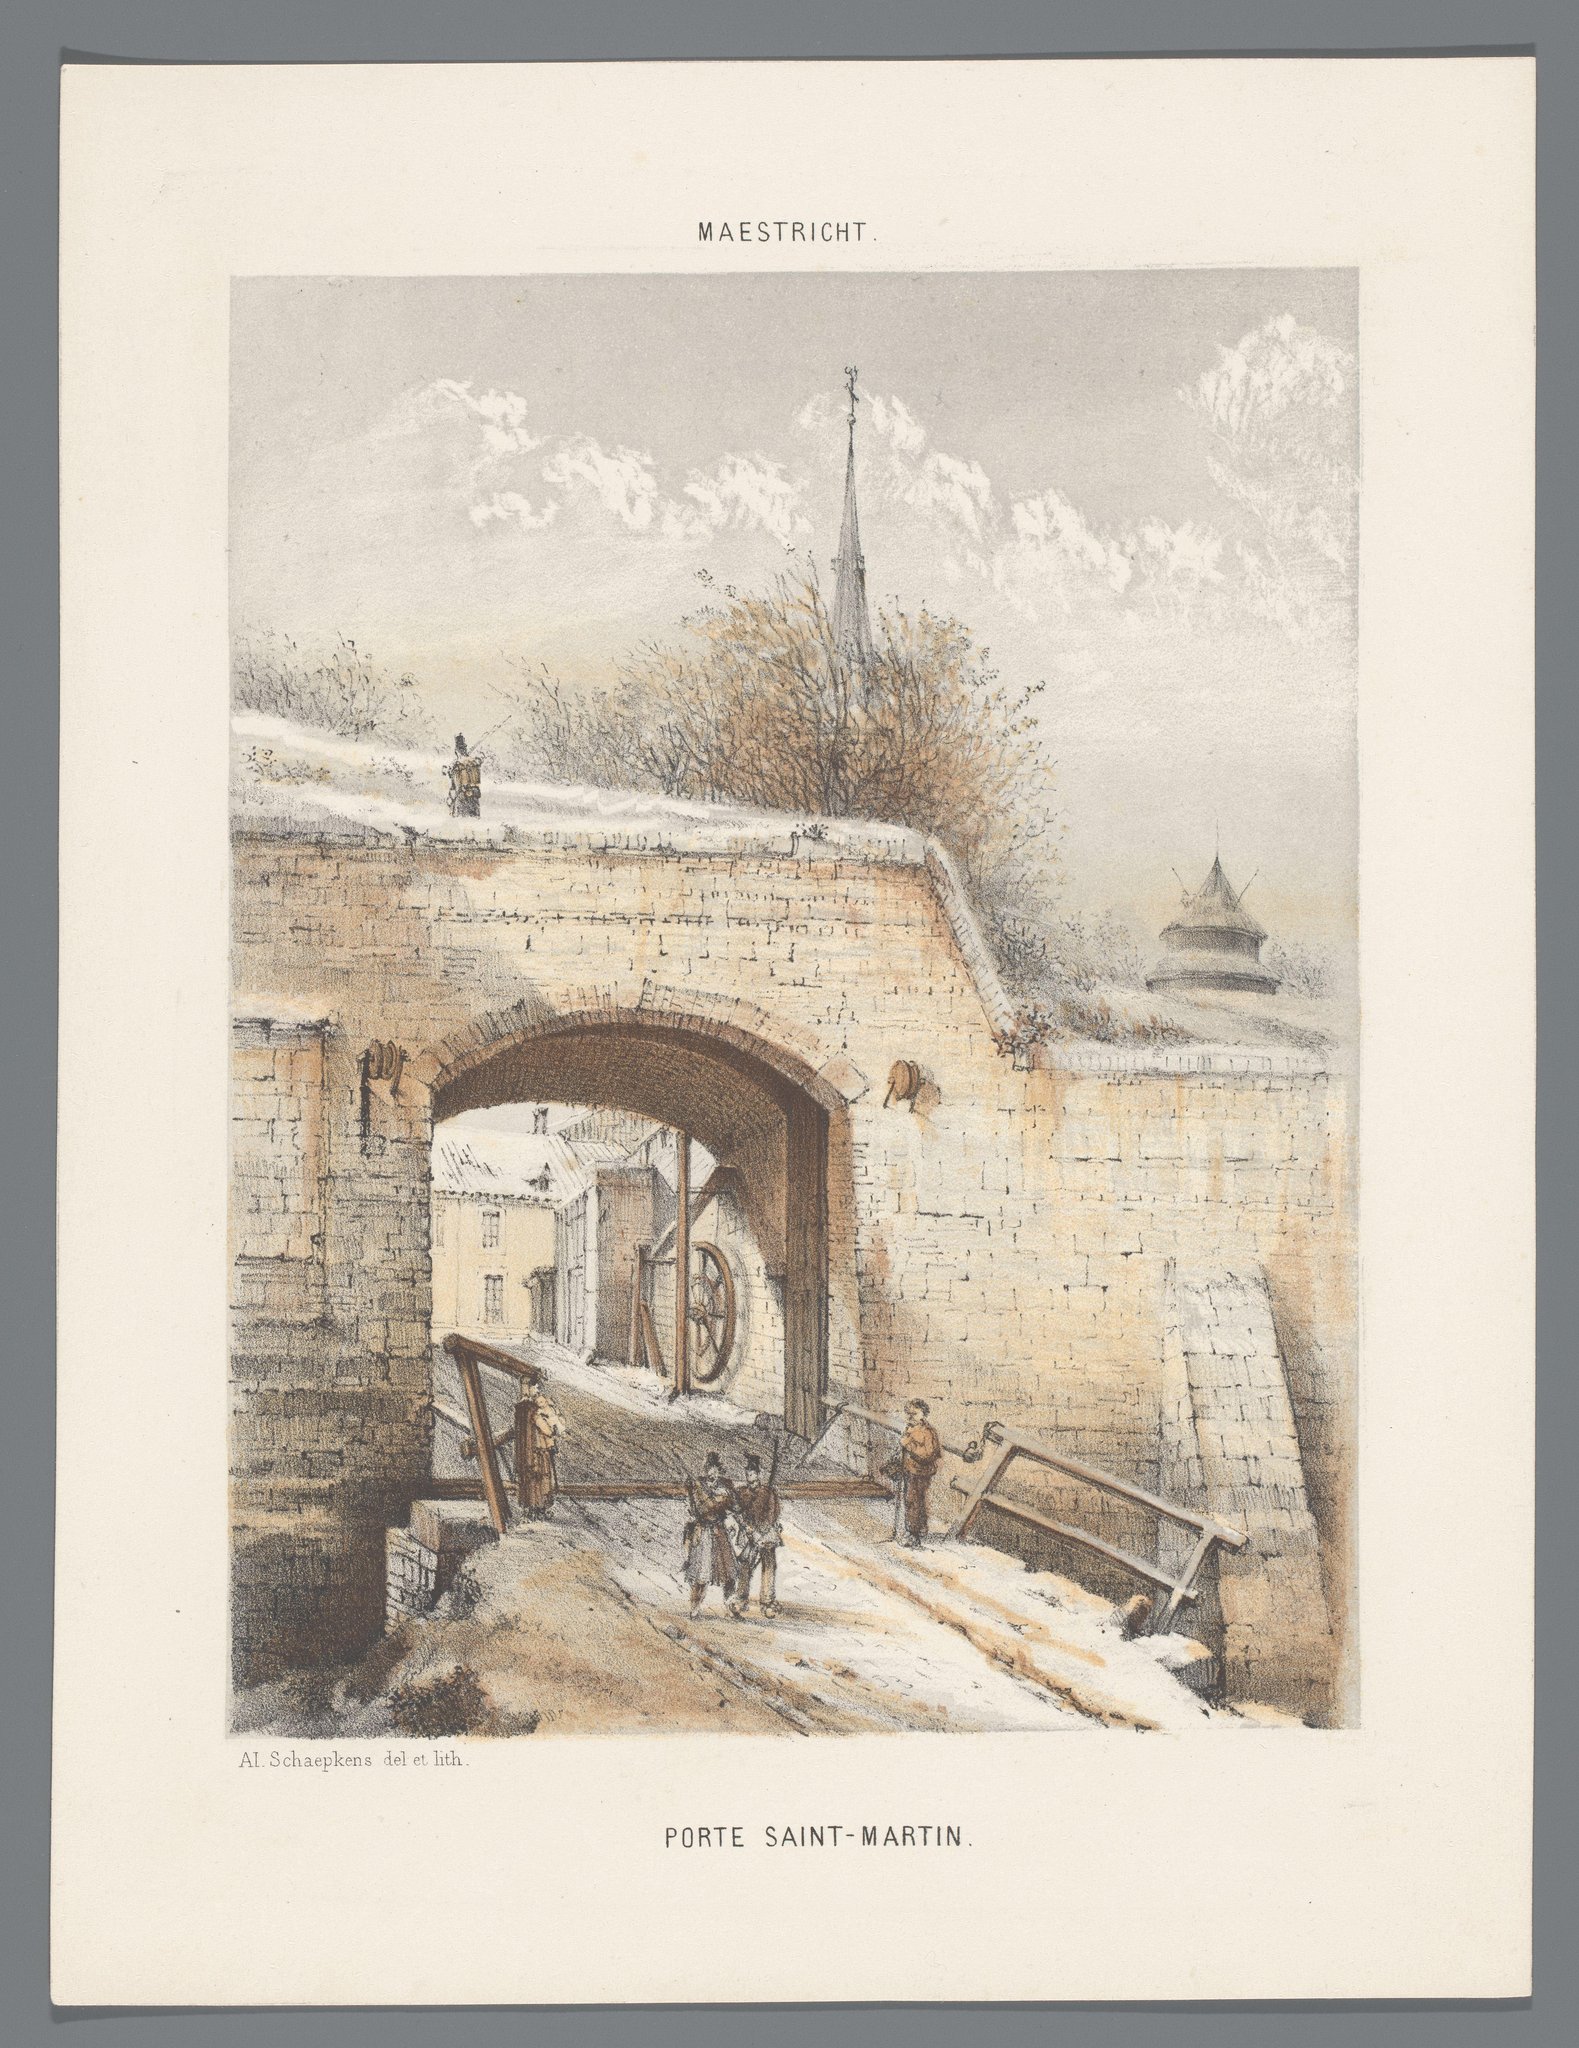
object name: print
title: Sint-Maartenspoort te Maastricht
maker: alexander schaepkens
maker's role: draughtsman, print maker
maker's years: 1815-1899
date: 1872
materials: paper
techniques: lithograph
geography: maastricht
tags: city-gate, maastricht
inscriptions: collector's mark: Lugt 2166, collector's mark: Lugt 2760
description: Veldzijde van de nieuwe Sint-Maartenspoort. Op de brug lopen figuren.